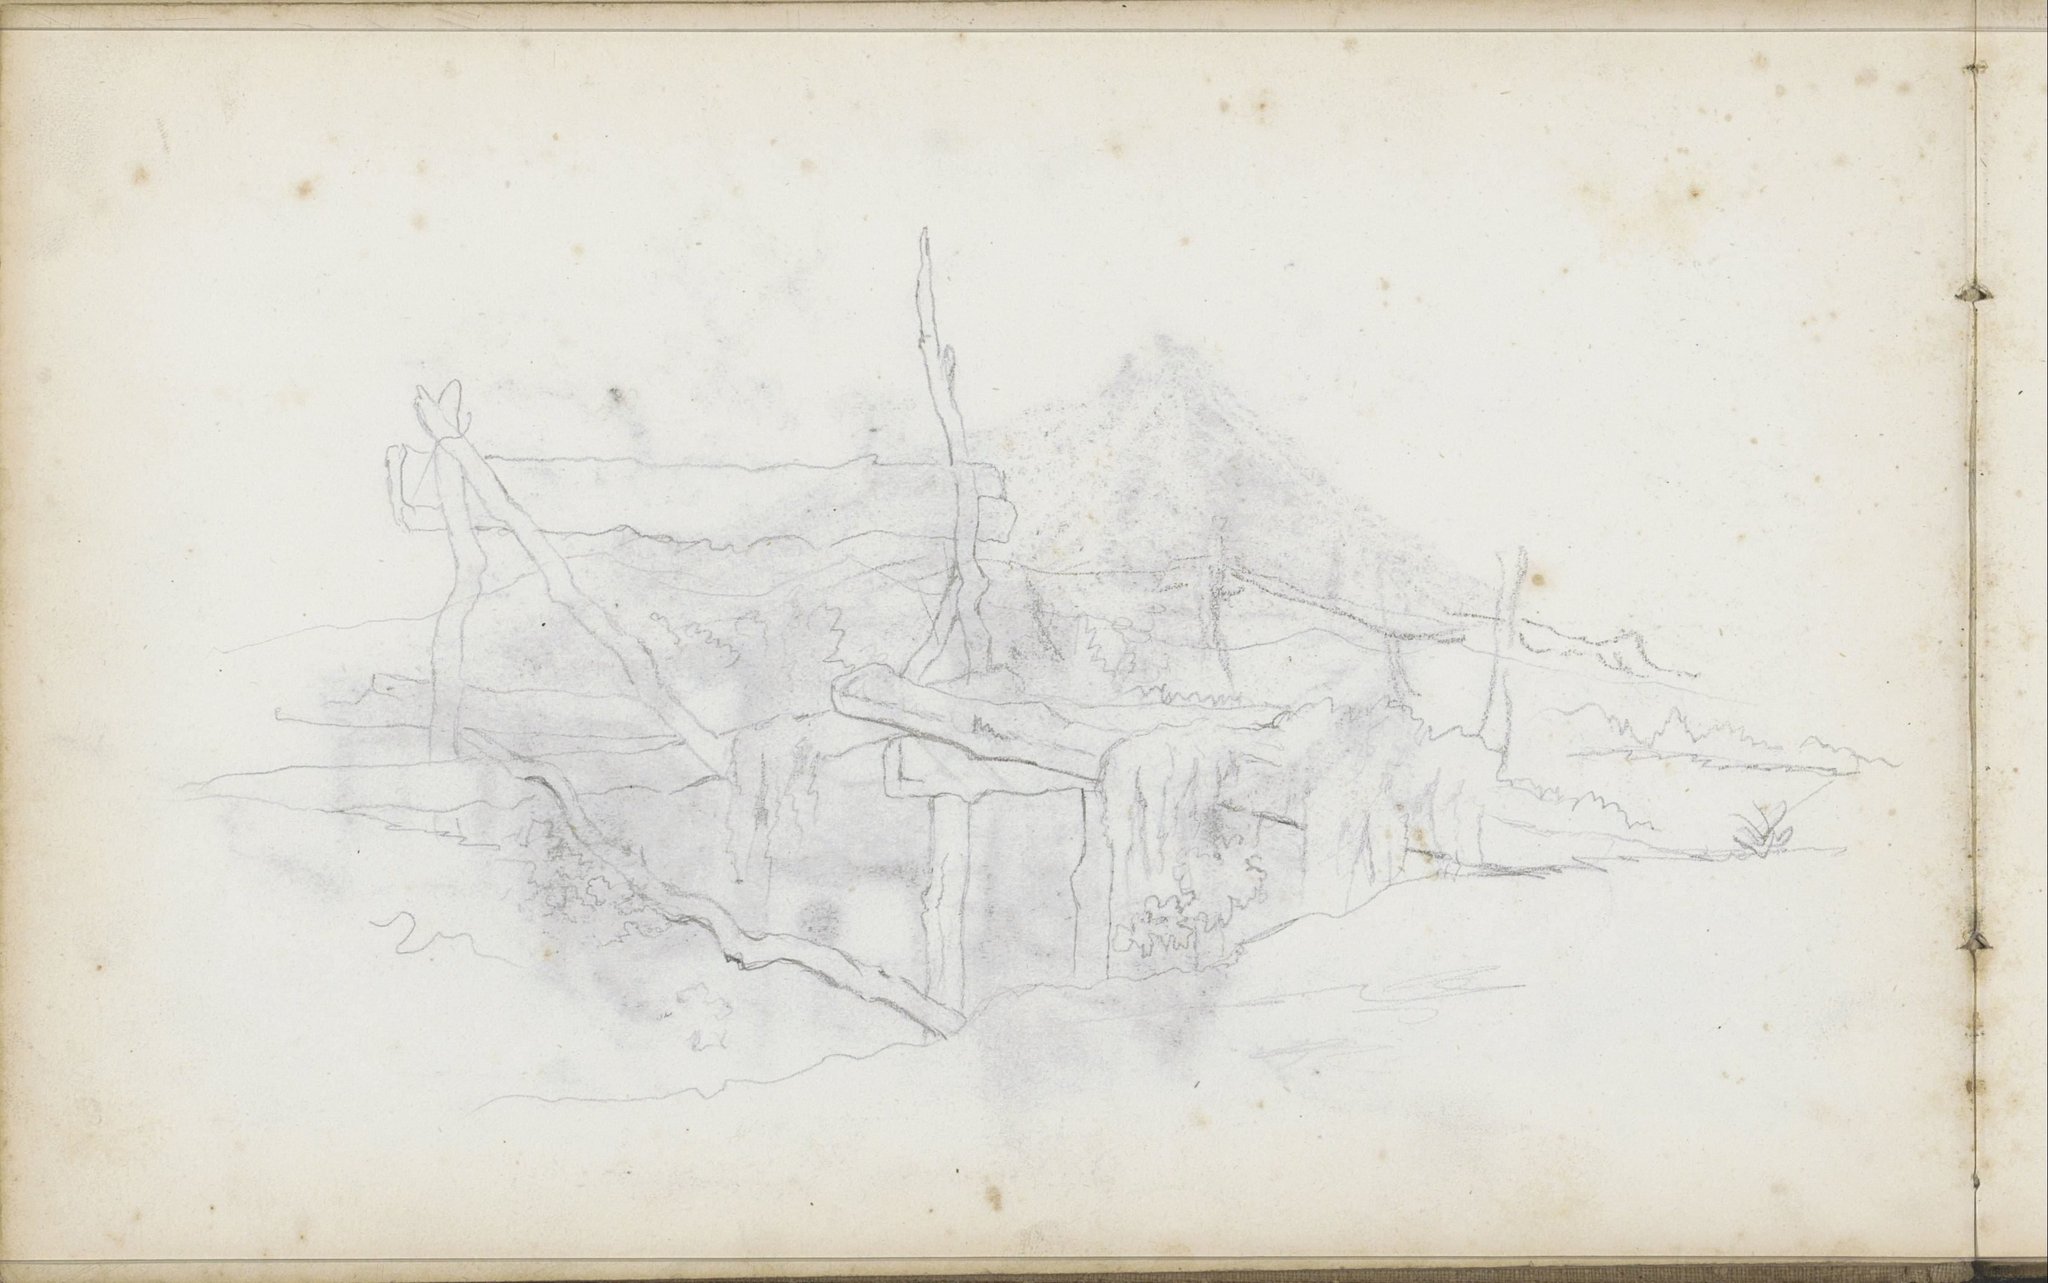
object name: sketchbook leaf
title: Met een hek afgezet gat in de grond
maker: willem cornelis rip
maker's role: draughtsman, painter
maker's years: 1856-1922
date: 1874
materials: chalk, paper, pencil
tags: pit, hole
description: Blad 10 verso uit een schetsboek met 47 bladen.